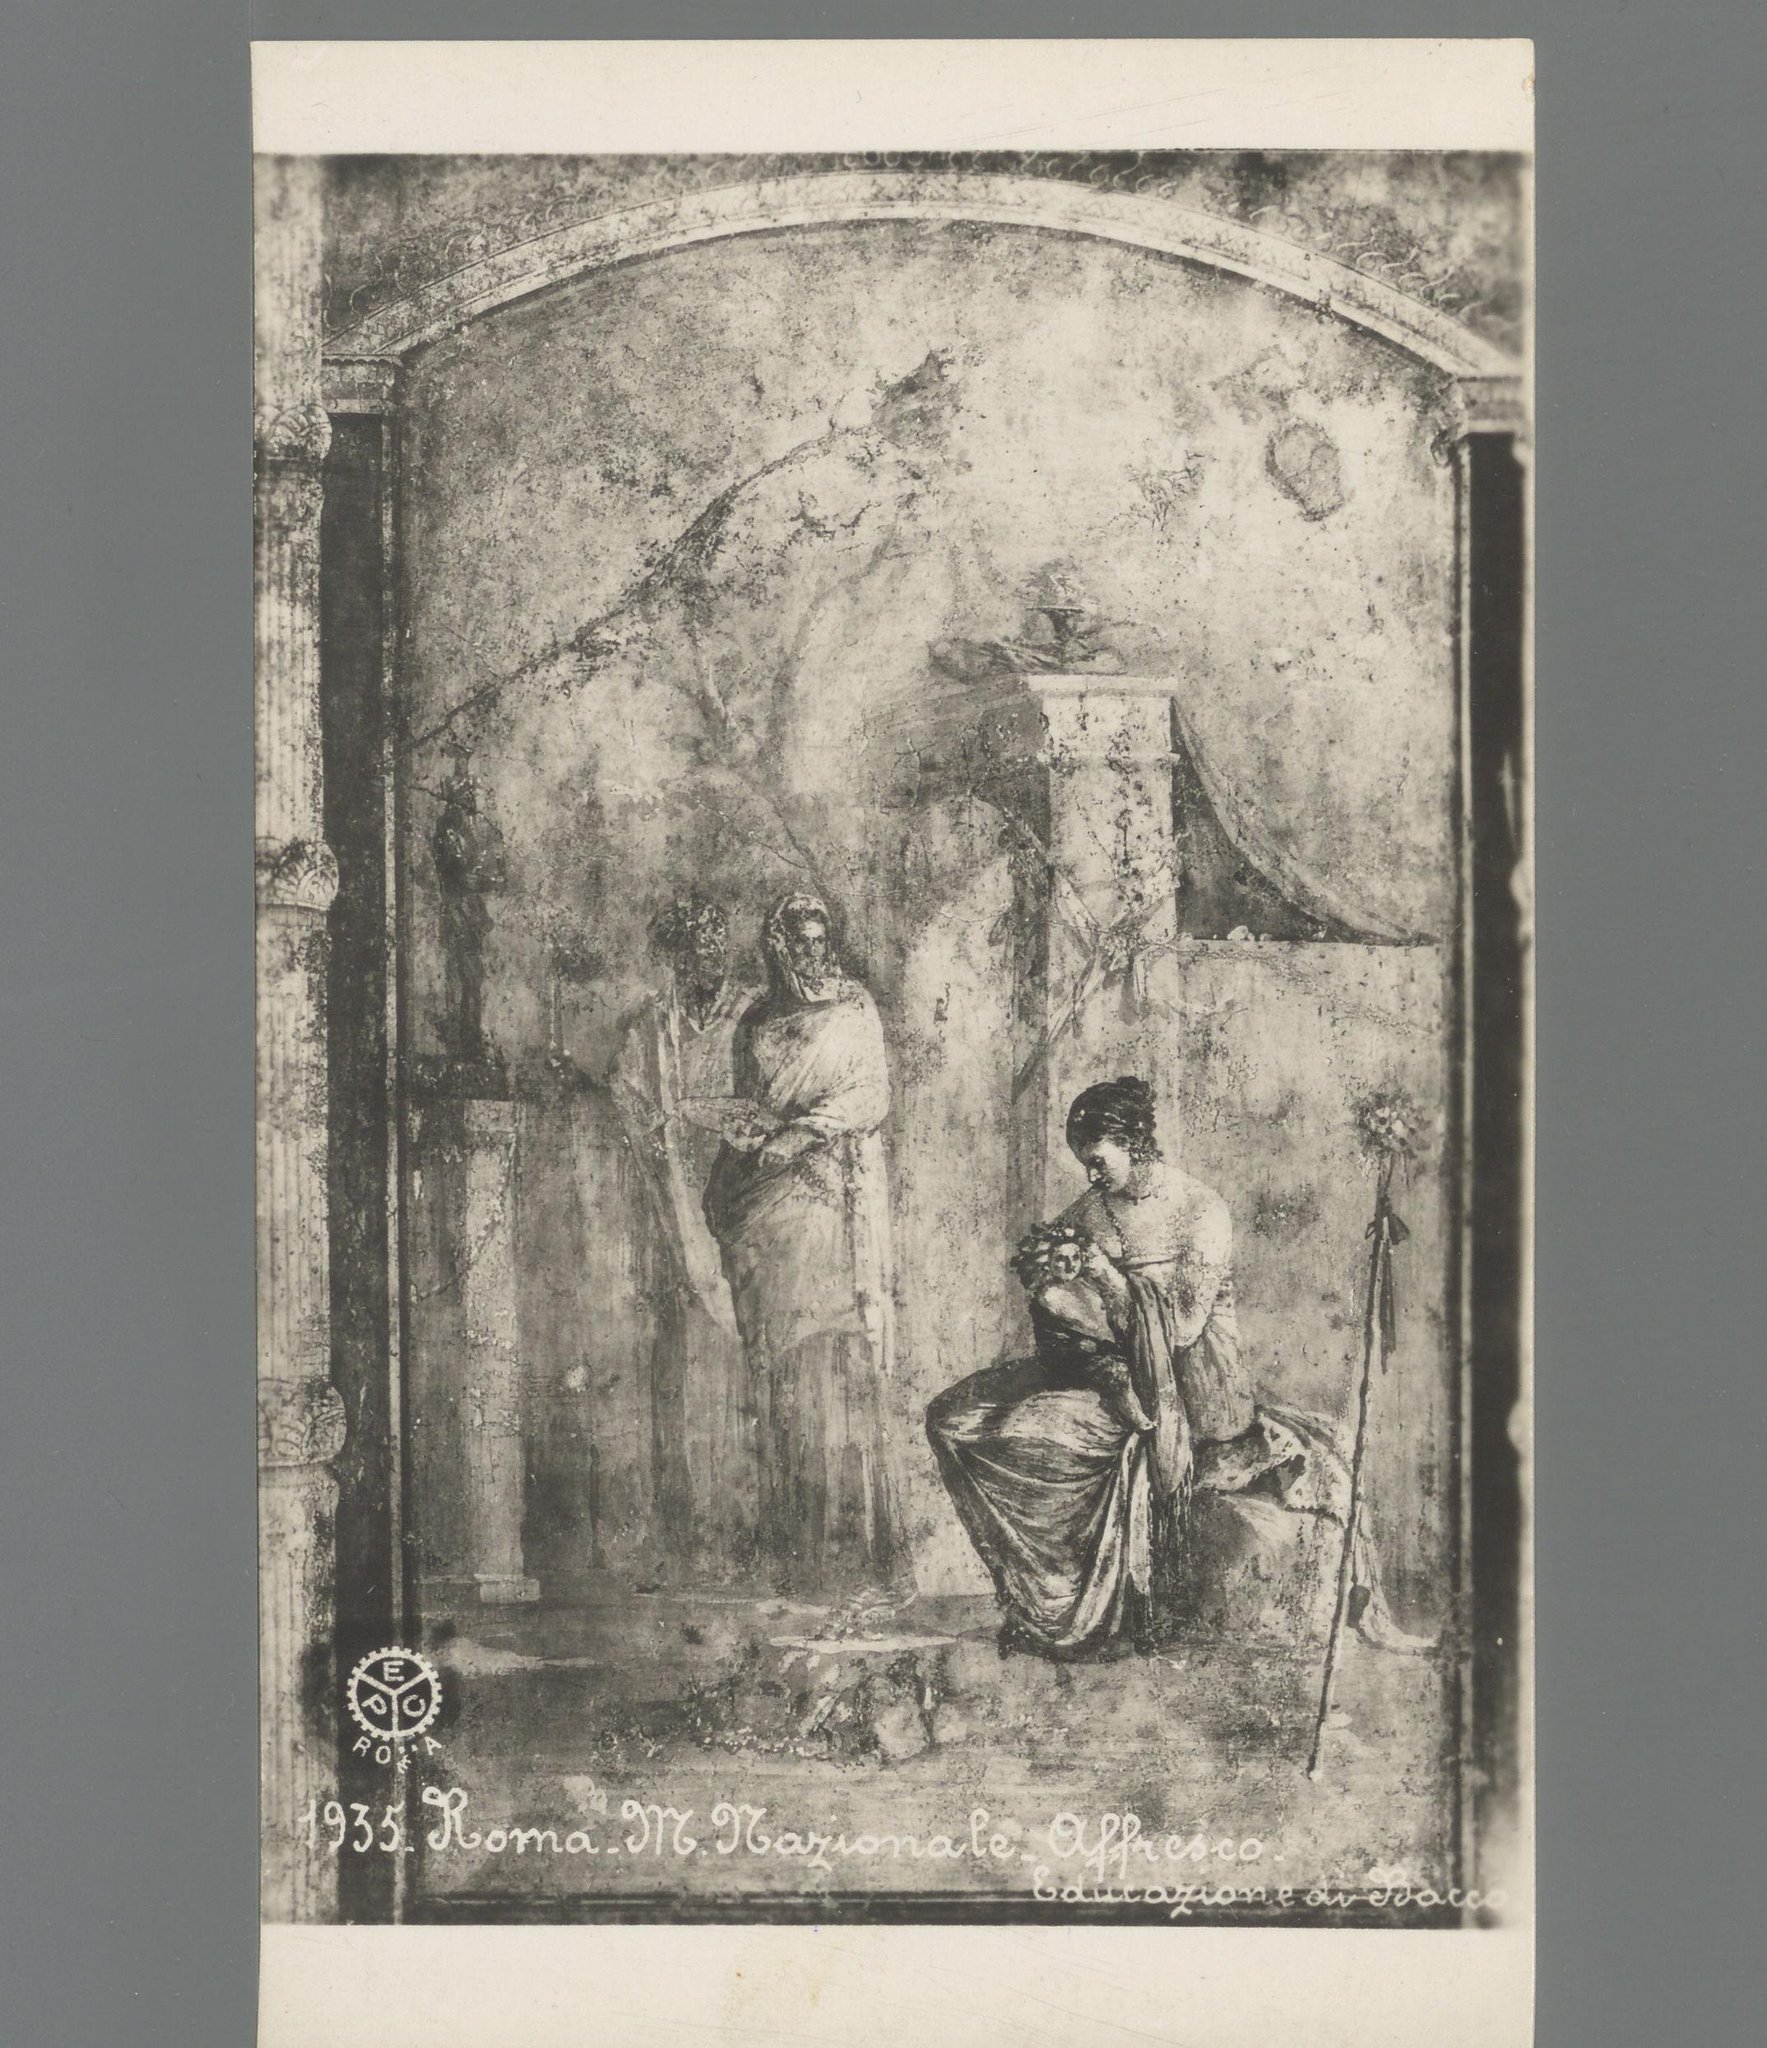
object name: photograph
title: Roma. M. Nazionale Affresco. Educazione di Bacco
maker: Anonymous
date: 1906-1930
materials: paper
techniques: gelatin silver print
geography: rome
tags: permanent exhibition, museum, picture, painting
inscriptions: monogram: ‘PEC Roma’, collector's mark: ‘AFE v S’, inscription: ‘P.E.C.’